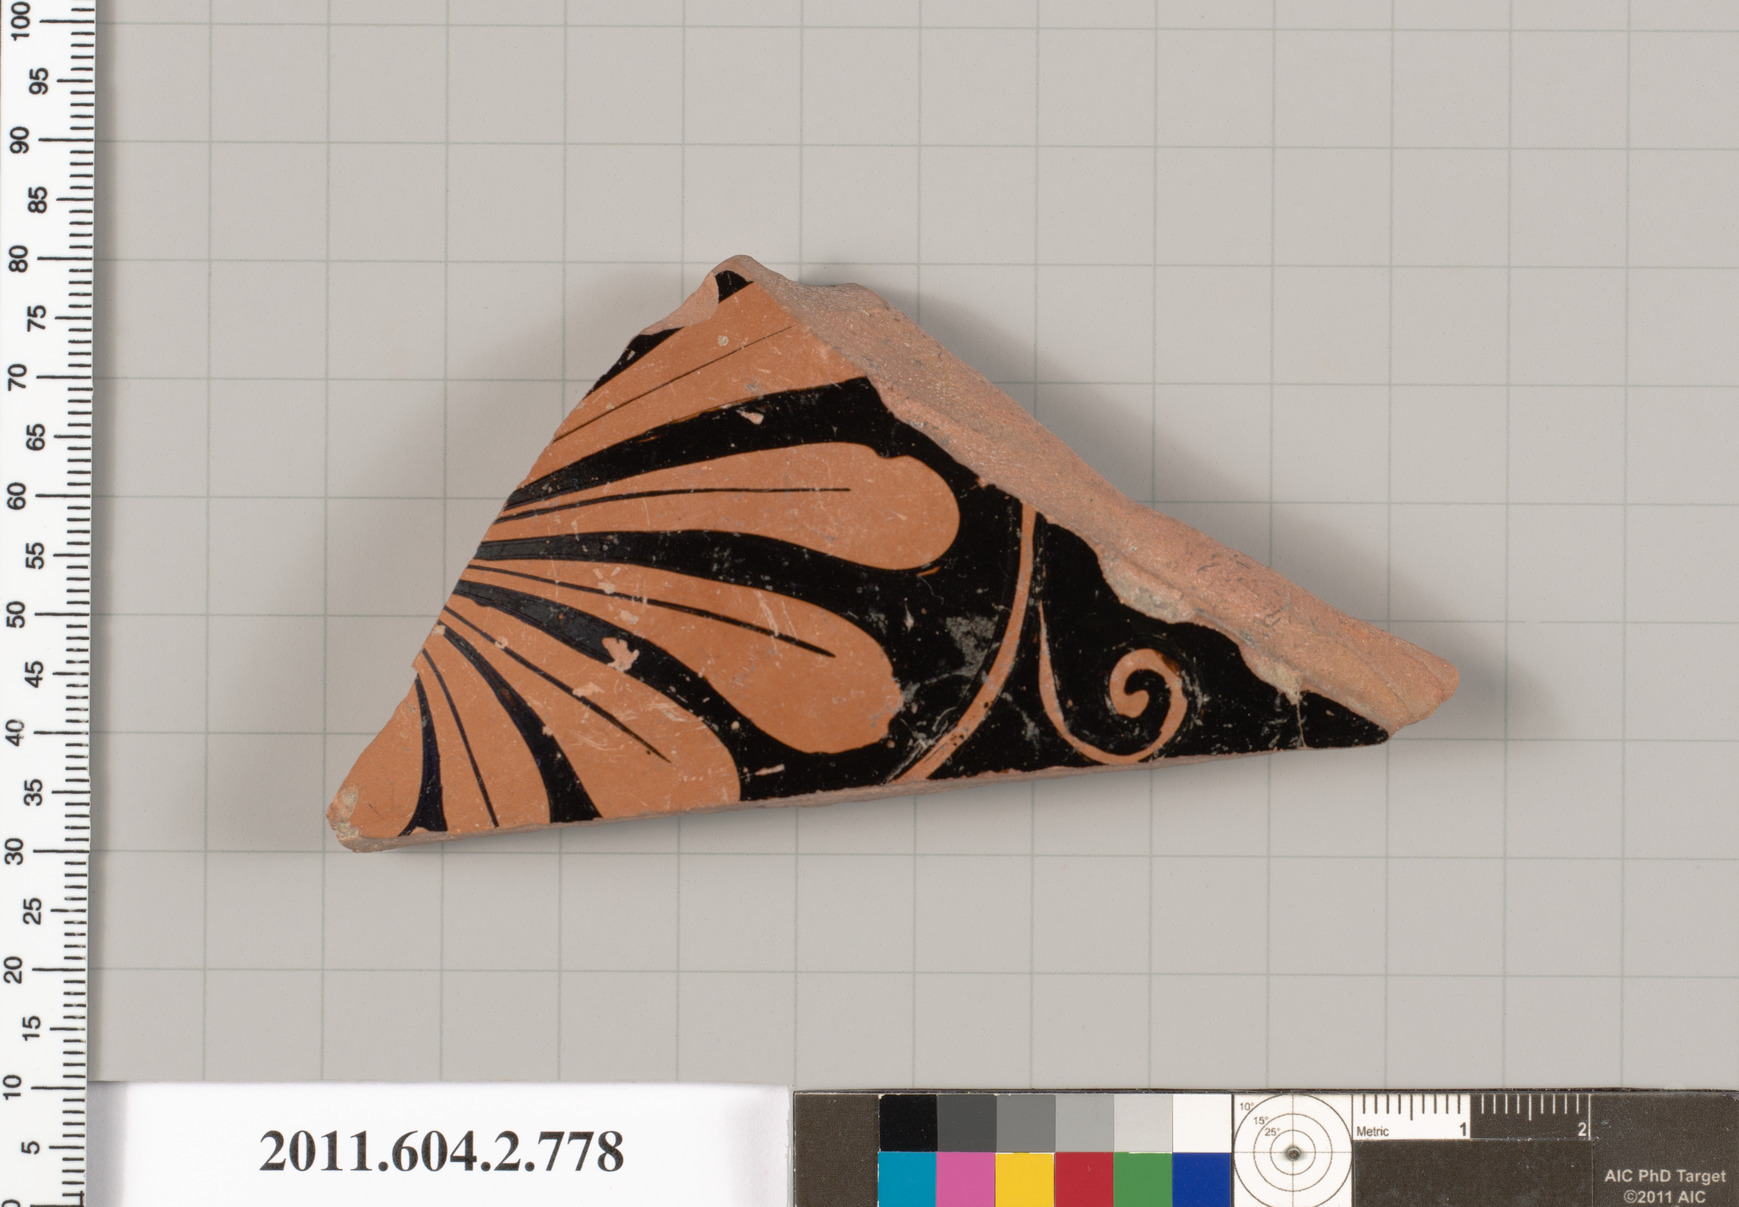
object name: calyx krater fragment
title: Terracotta fragment of a calyx-krater (bowl for mixing wine and water)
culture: greek, attic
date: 500-480 BCE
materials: terracotta